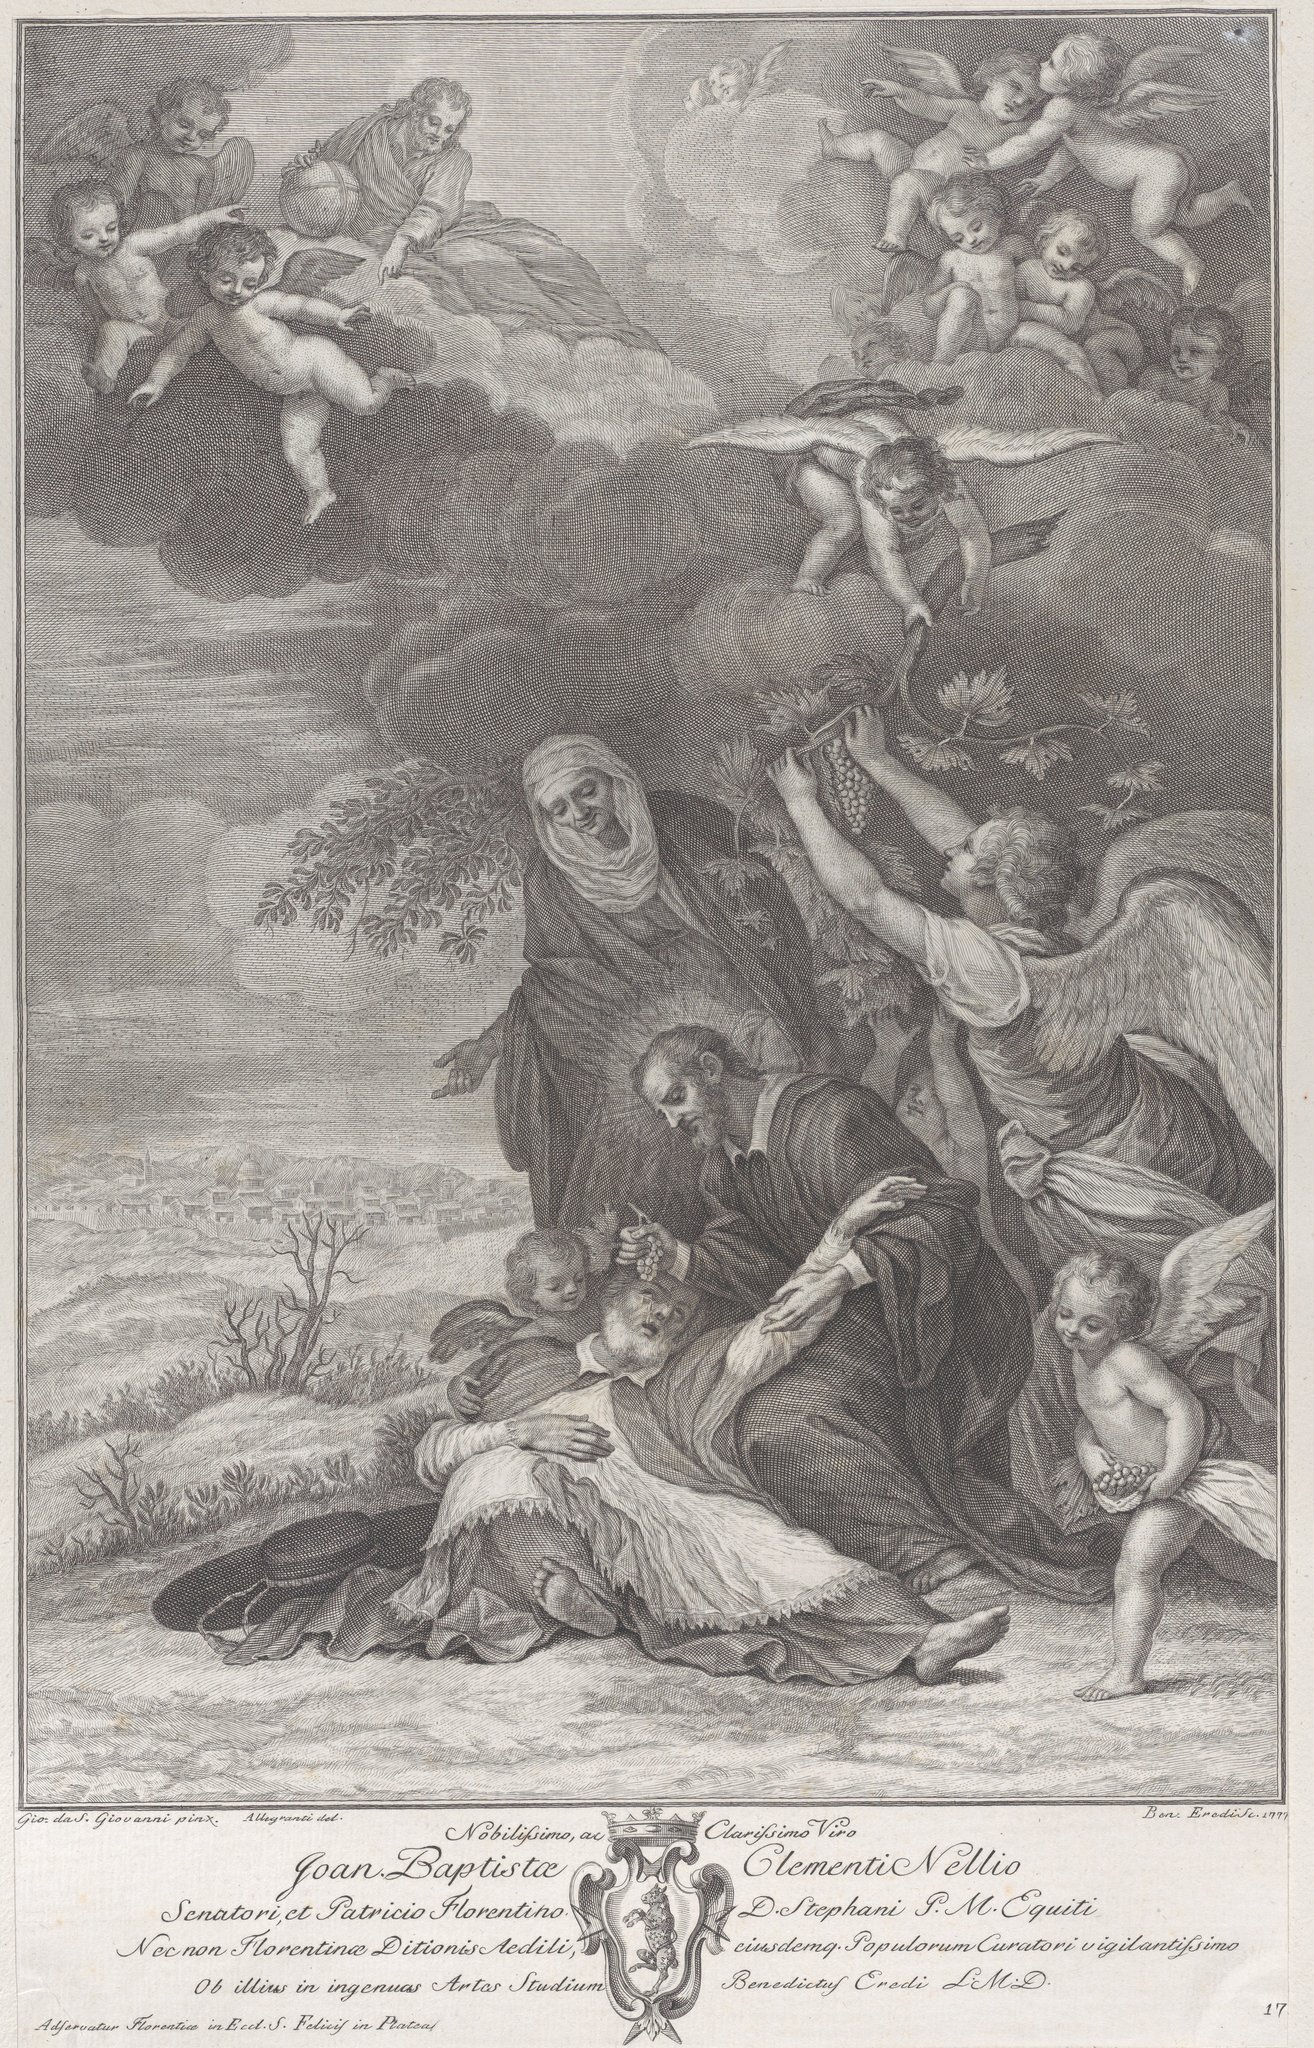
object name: print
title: Miracle of a Saint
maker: benedetto eredi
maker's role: artist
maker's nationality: italian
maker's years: 1750-1815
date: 1777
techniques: etching